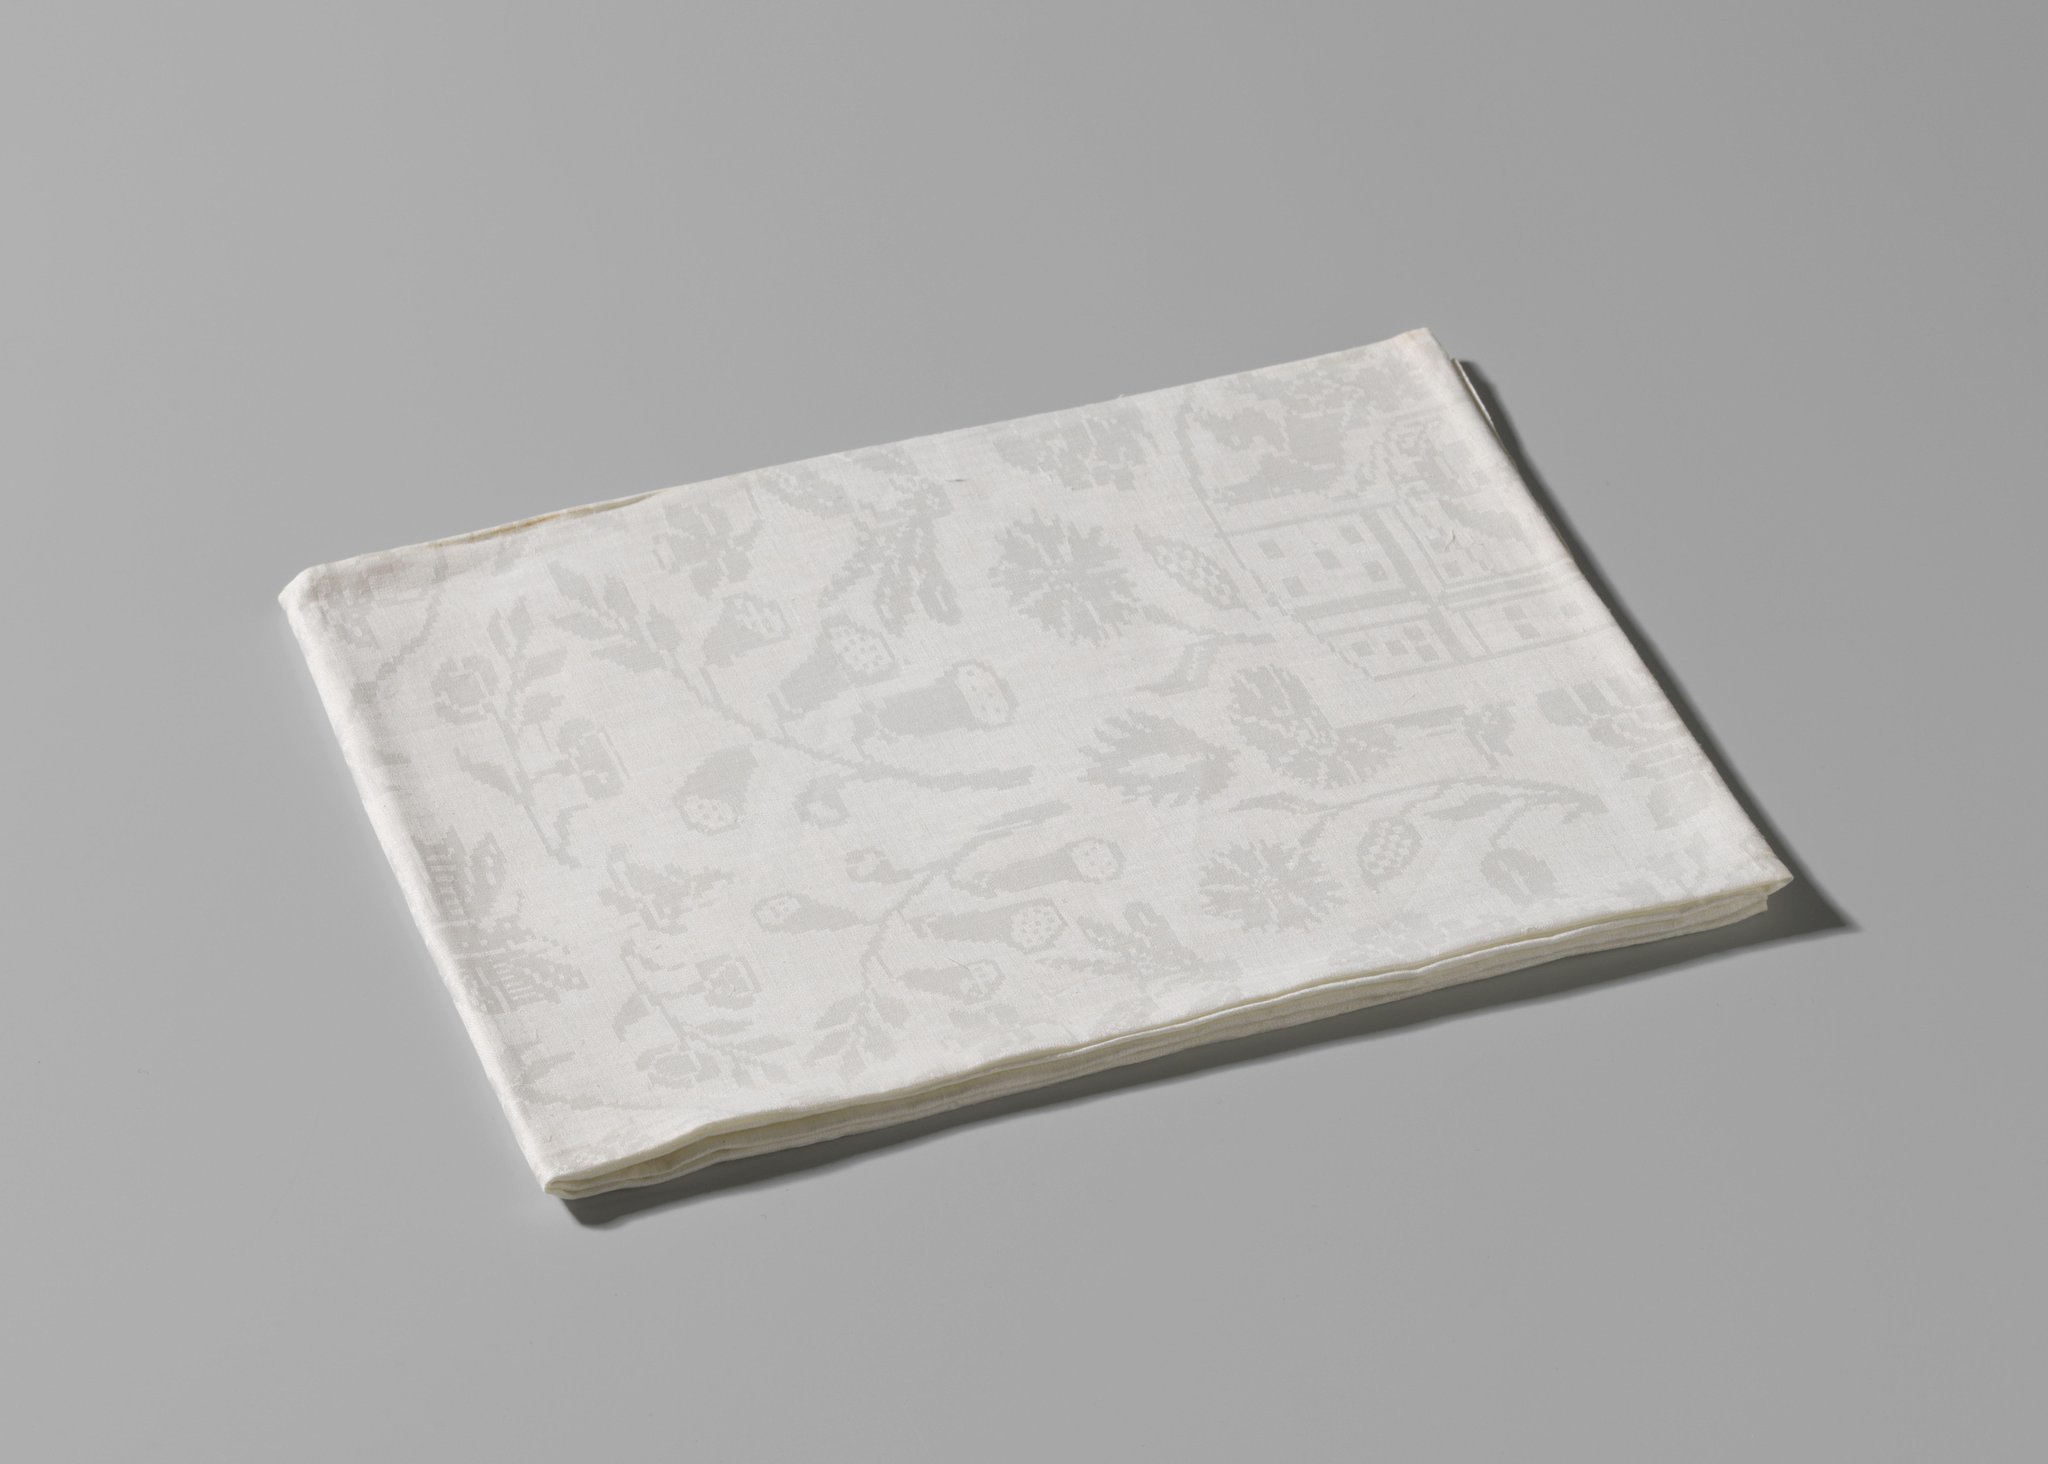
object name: woven material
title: Servet van wit linnendamast met de gekoppelde wapens Von Inn- und Kniphausen en Van Ewsum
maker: Anonymous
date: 1665-1670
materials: linen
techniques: damask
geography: northern netherlands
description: Servet van wit linnendamast met bloempatroon romdom de gekoppelde wapens Von Inn- und Kniphausen en Van Ewsum. Gemerkt: kroon LE 17.